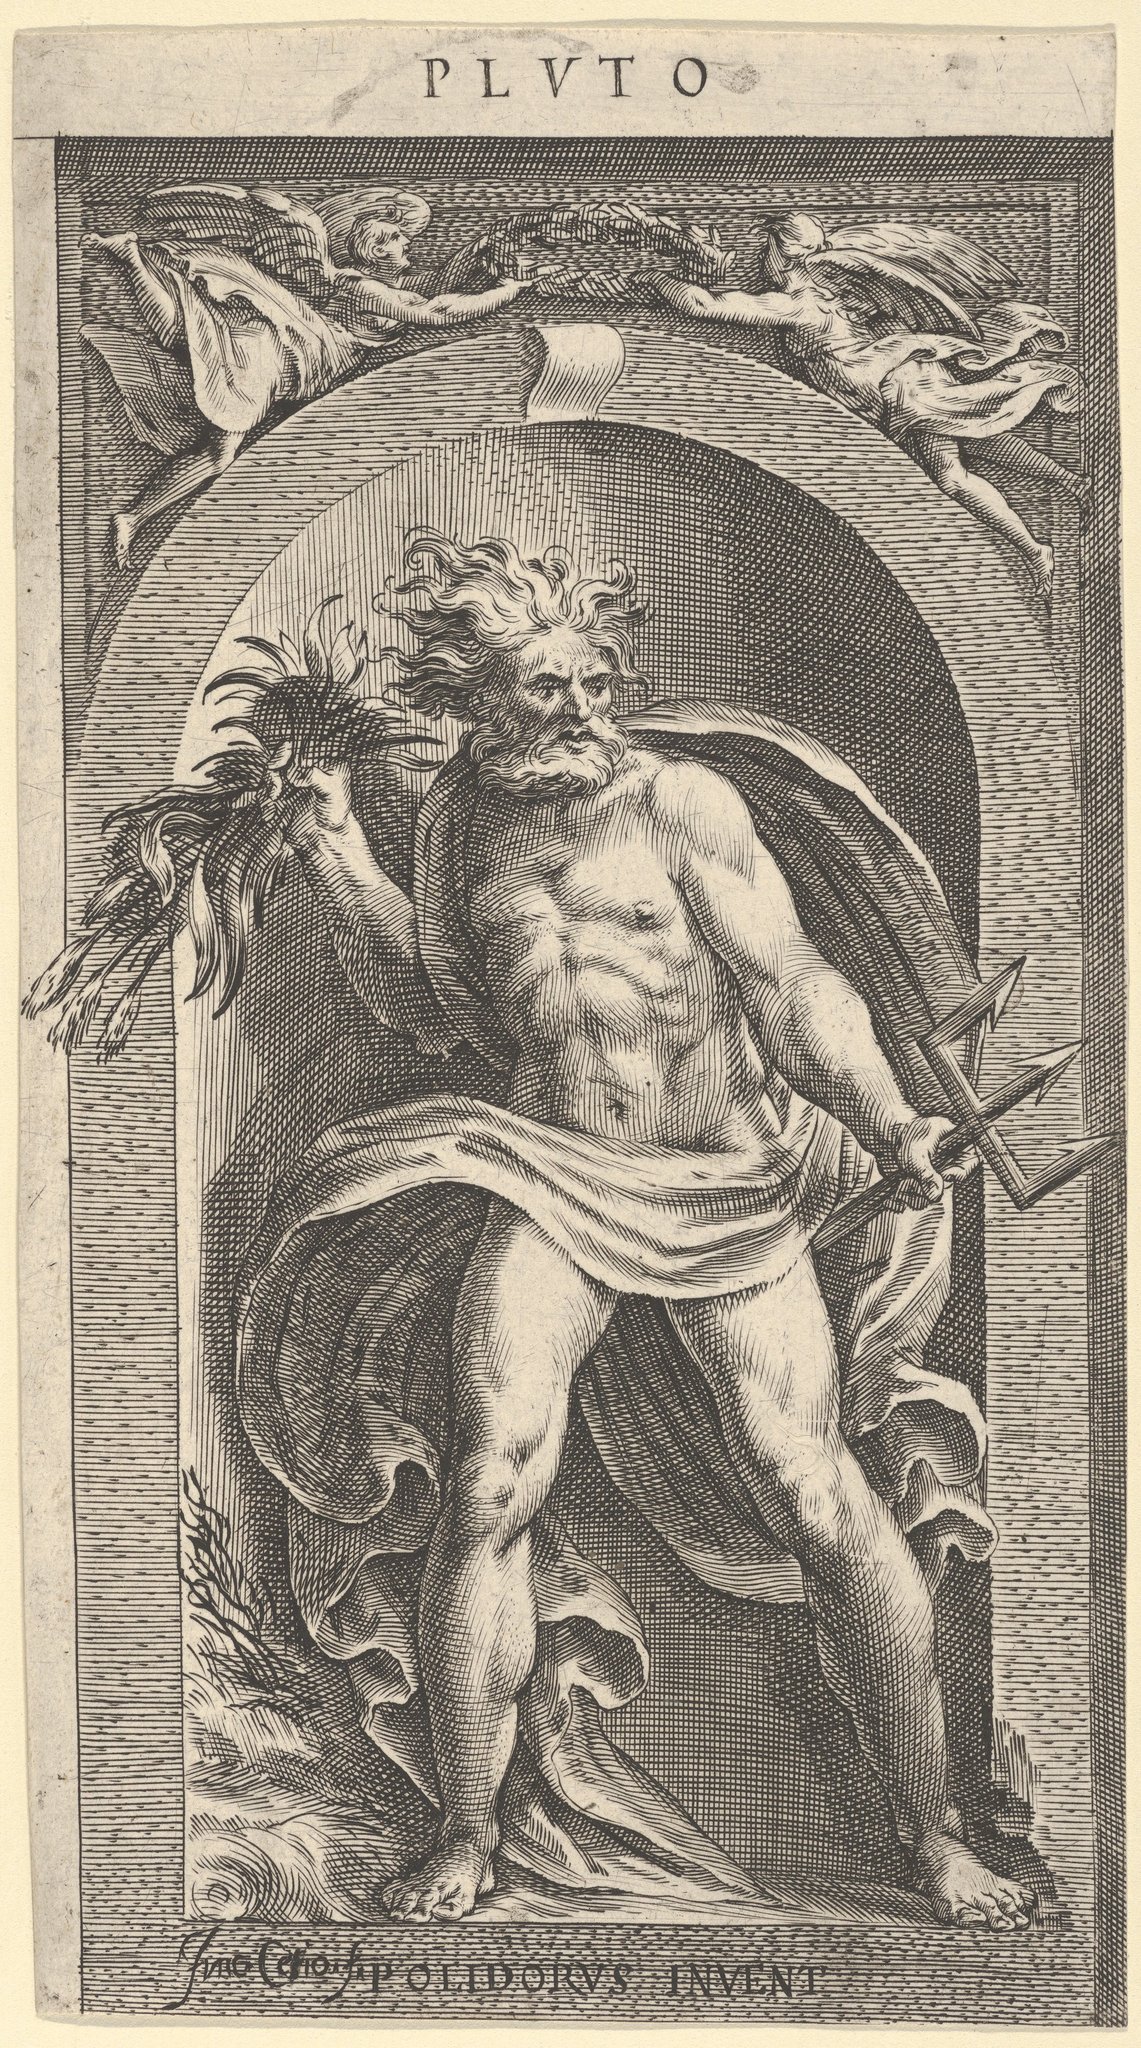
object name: print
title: Neptune standing in a niche holding a trident in his left hand, foliage in his right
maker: cherubino alberti (zaccaria mattia)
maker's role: artist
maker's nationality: italian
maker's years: 1553-1615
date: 1570-1615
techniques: engraving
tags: spears,neptune